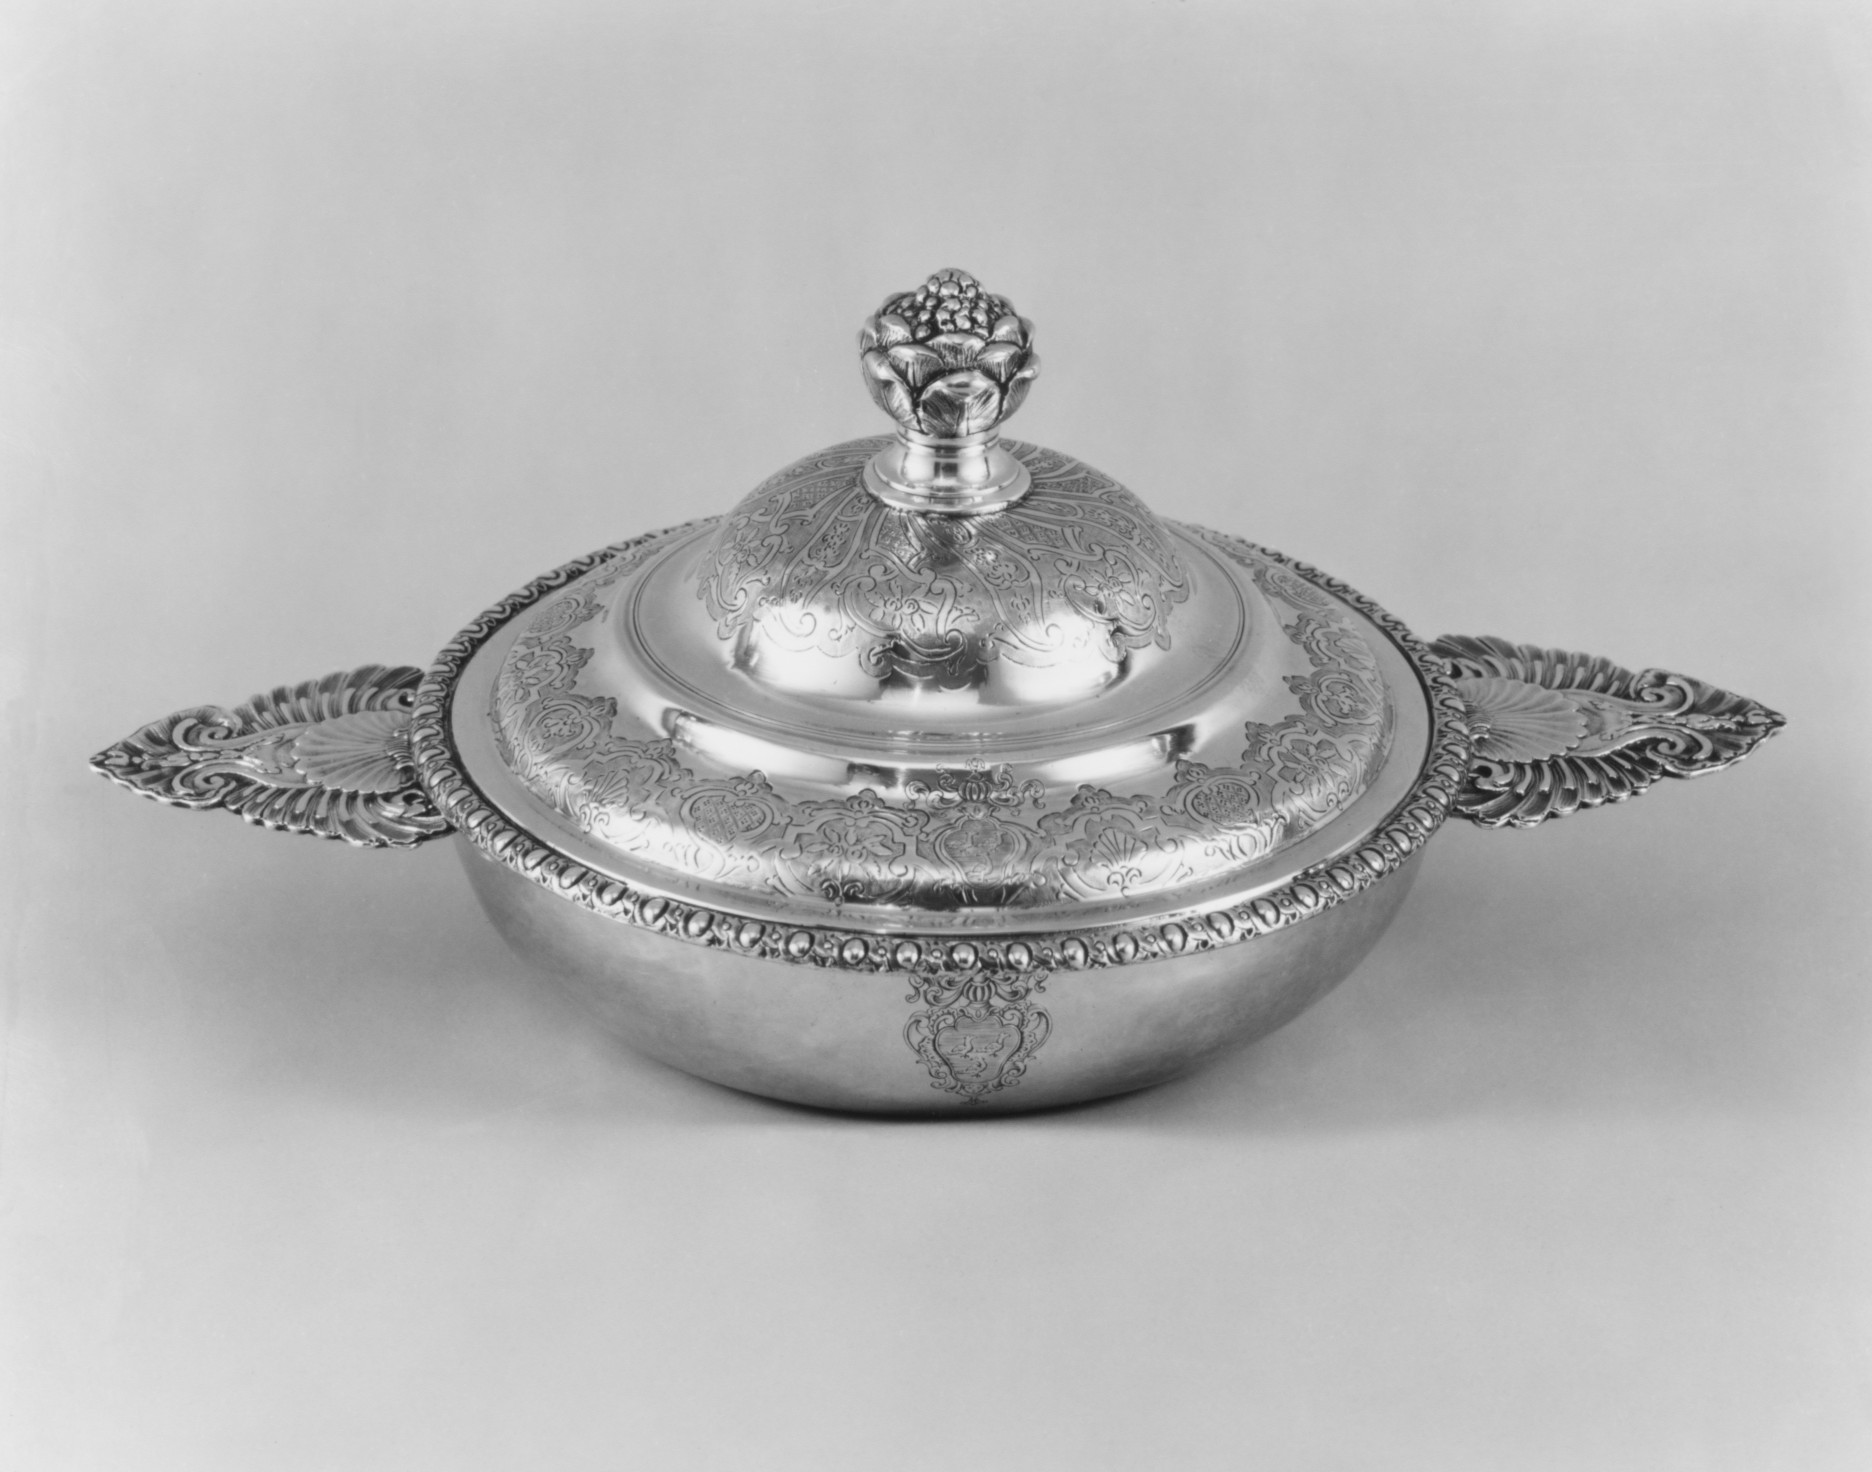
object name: broth bowl with cover écuelle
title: Broth bowl with cover (écuelle)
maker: pierre-henry chéret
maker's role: maker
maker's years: 1687-1787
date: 1749-1750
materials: silver